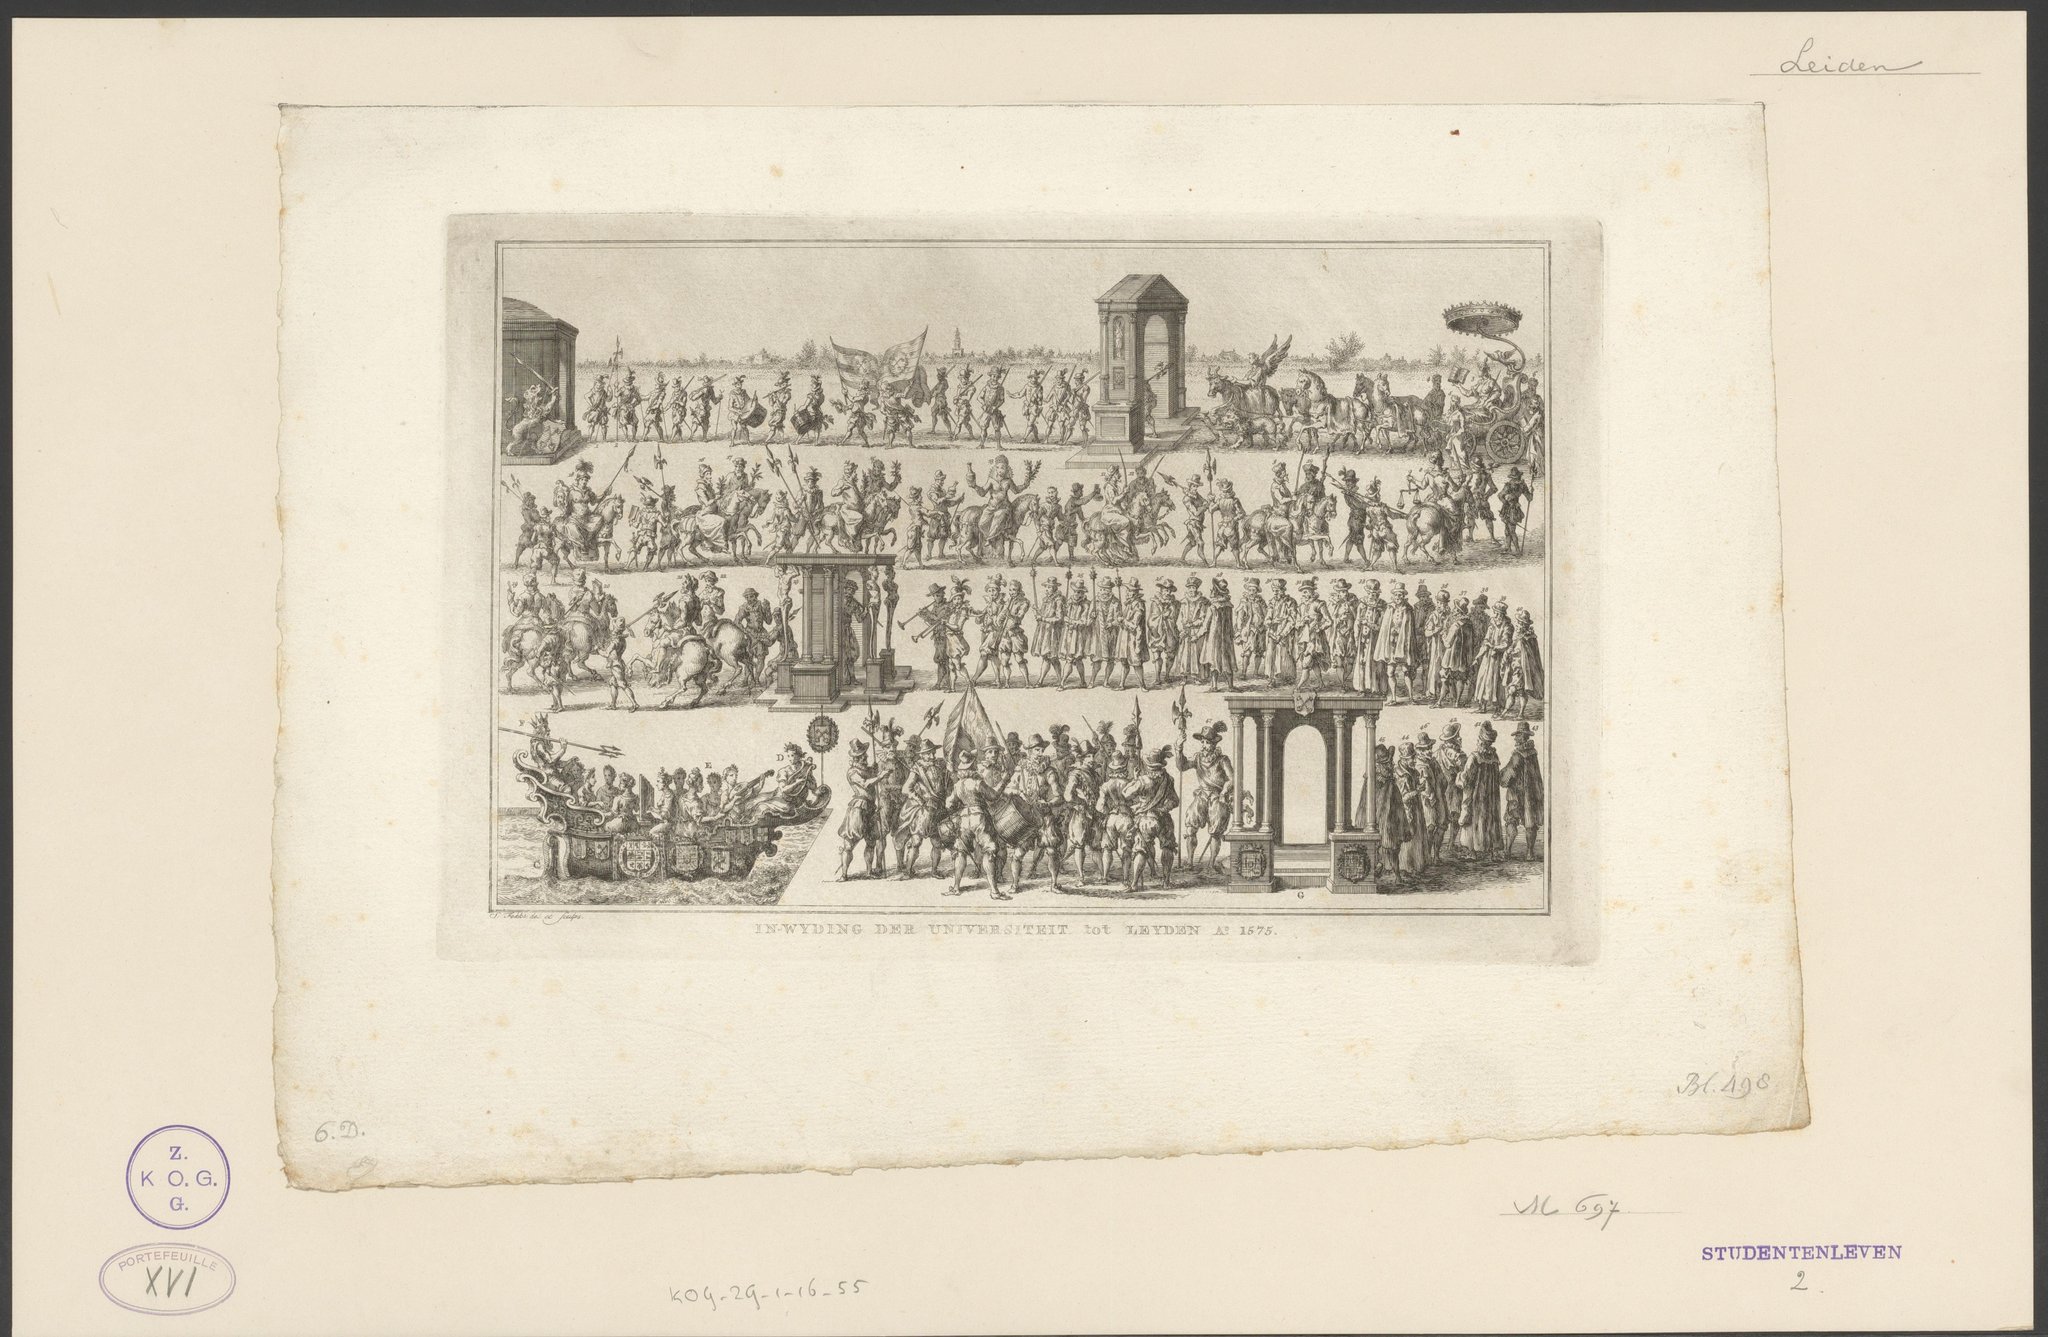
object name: print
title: In-wyding der Universiteit tot Leyden Ao. 1575.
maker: simon fokke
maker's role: draughtsman, print maker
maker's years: 1712-1784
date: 1752-1784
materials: paper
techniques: engraving, etching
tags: festivities (+ parade, pageant, cavalcade ~ festive activities), student life, founding of a university, leiden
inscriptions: stamp, collector's mark: Lugt 1641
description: Optocht bij de inwijding van Universiteit van Leiden, 8 februari 1575. Stoet in vier rijen boven elkaar afgebeeld. Linksonder het schip met Apollo, Neptunus en de negen muzen. Verder soldaten, muzikanten, allegorische figuren die de wetenschappen verbeelden, hoogwaardigheidsbekleders, stadsboden en professoren. Figuren en onderdelen in de voorstelling zijn aangeduid met cijfers en letters. Onderwerpsrubrieken binnen de Atlas Zeden en Gewoonten: Onderwijs en Wetenschappen, Studentenleven.